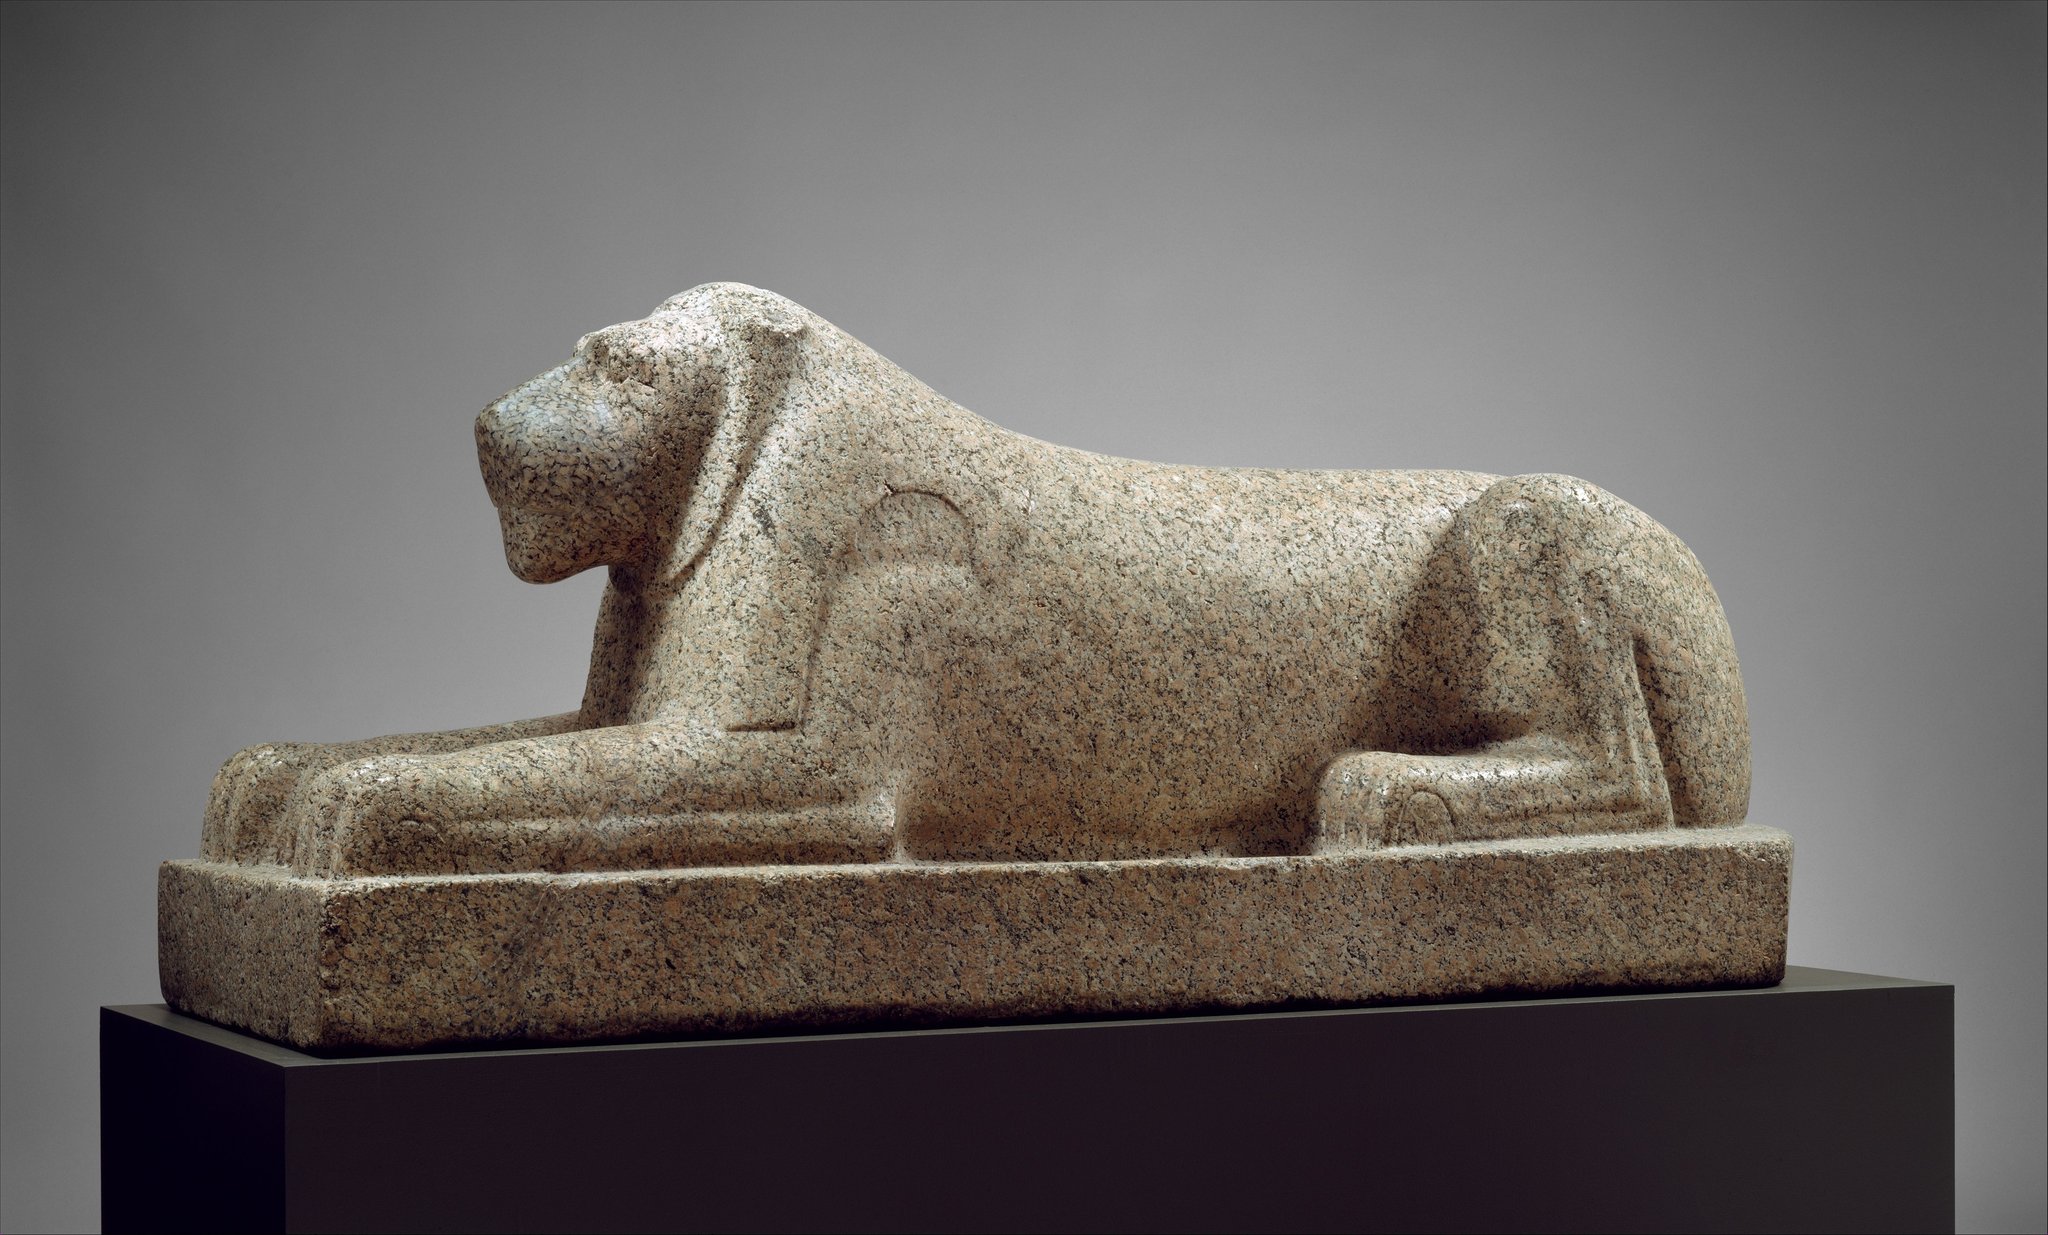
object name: statue, lion recumbent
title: Recumbent Lion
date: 2575-2450 BCE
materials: granite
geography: egypt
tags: lions